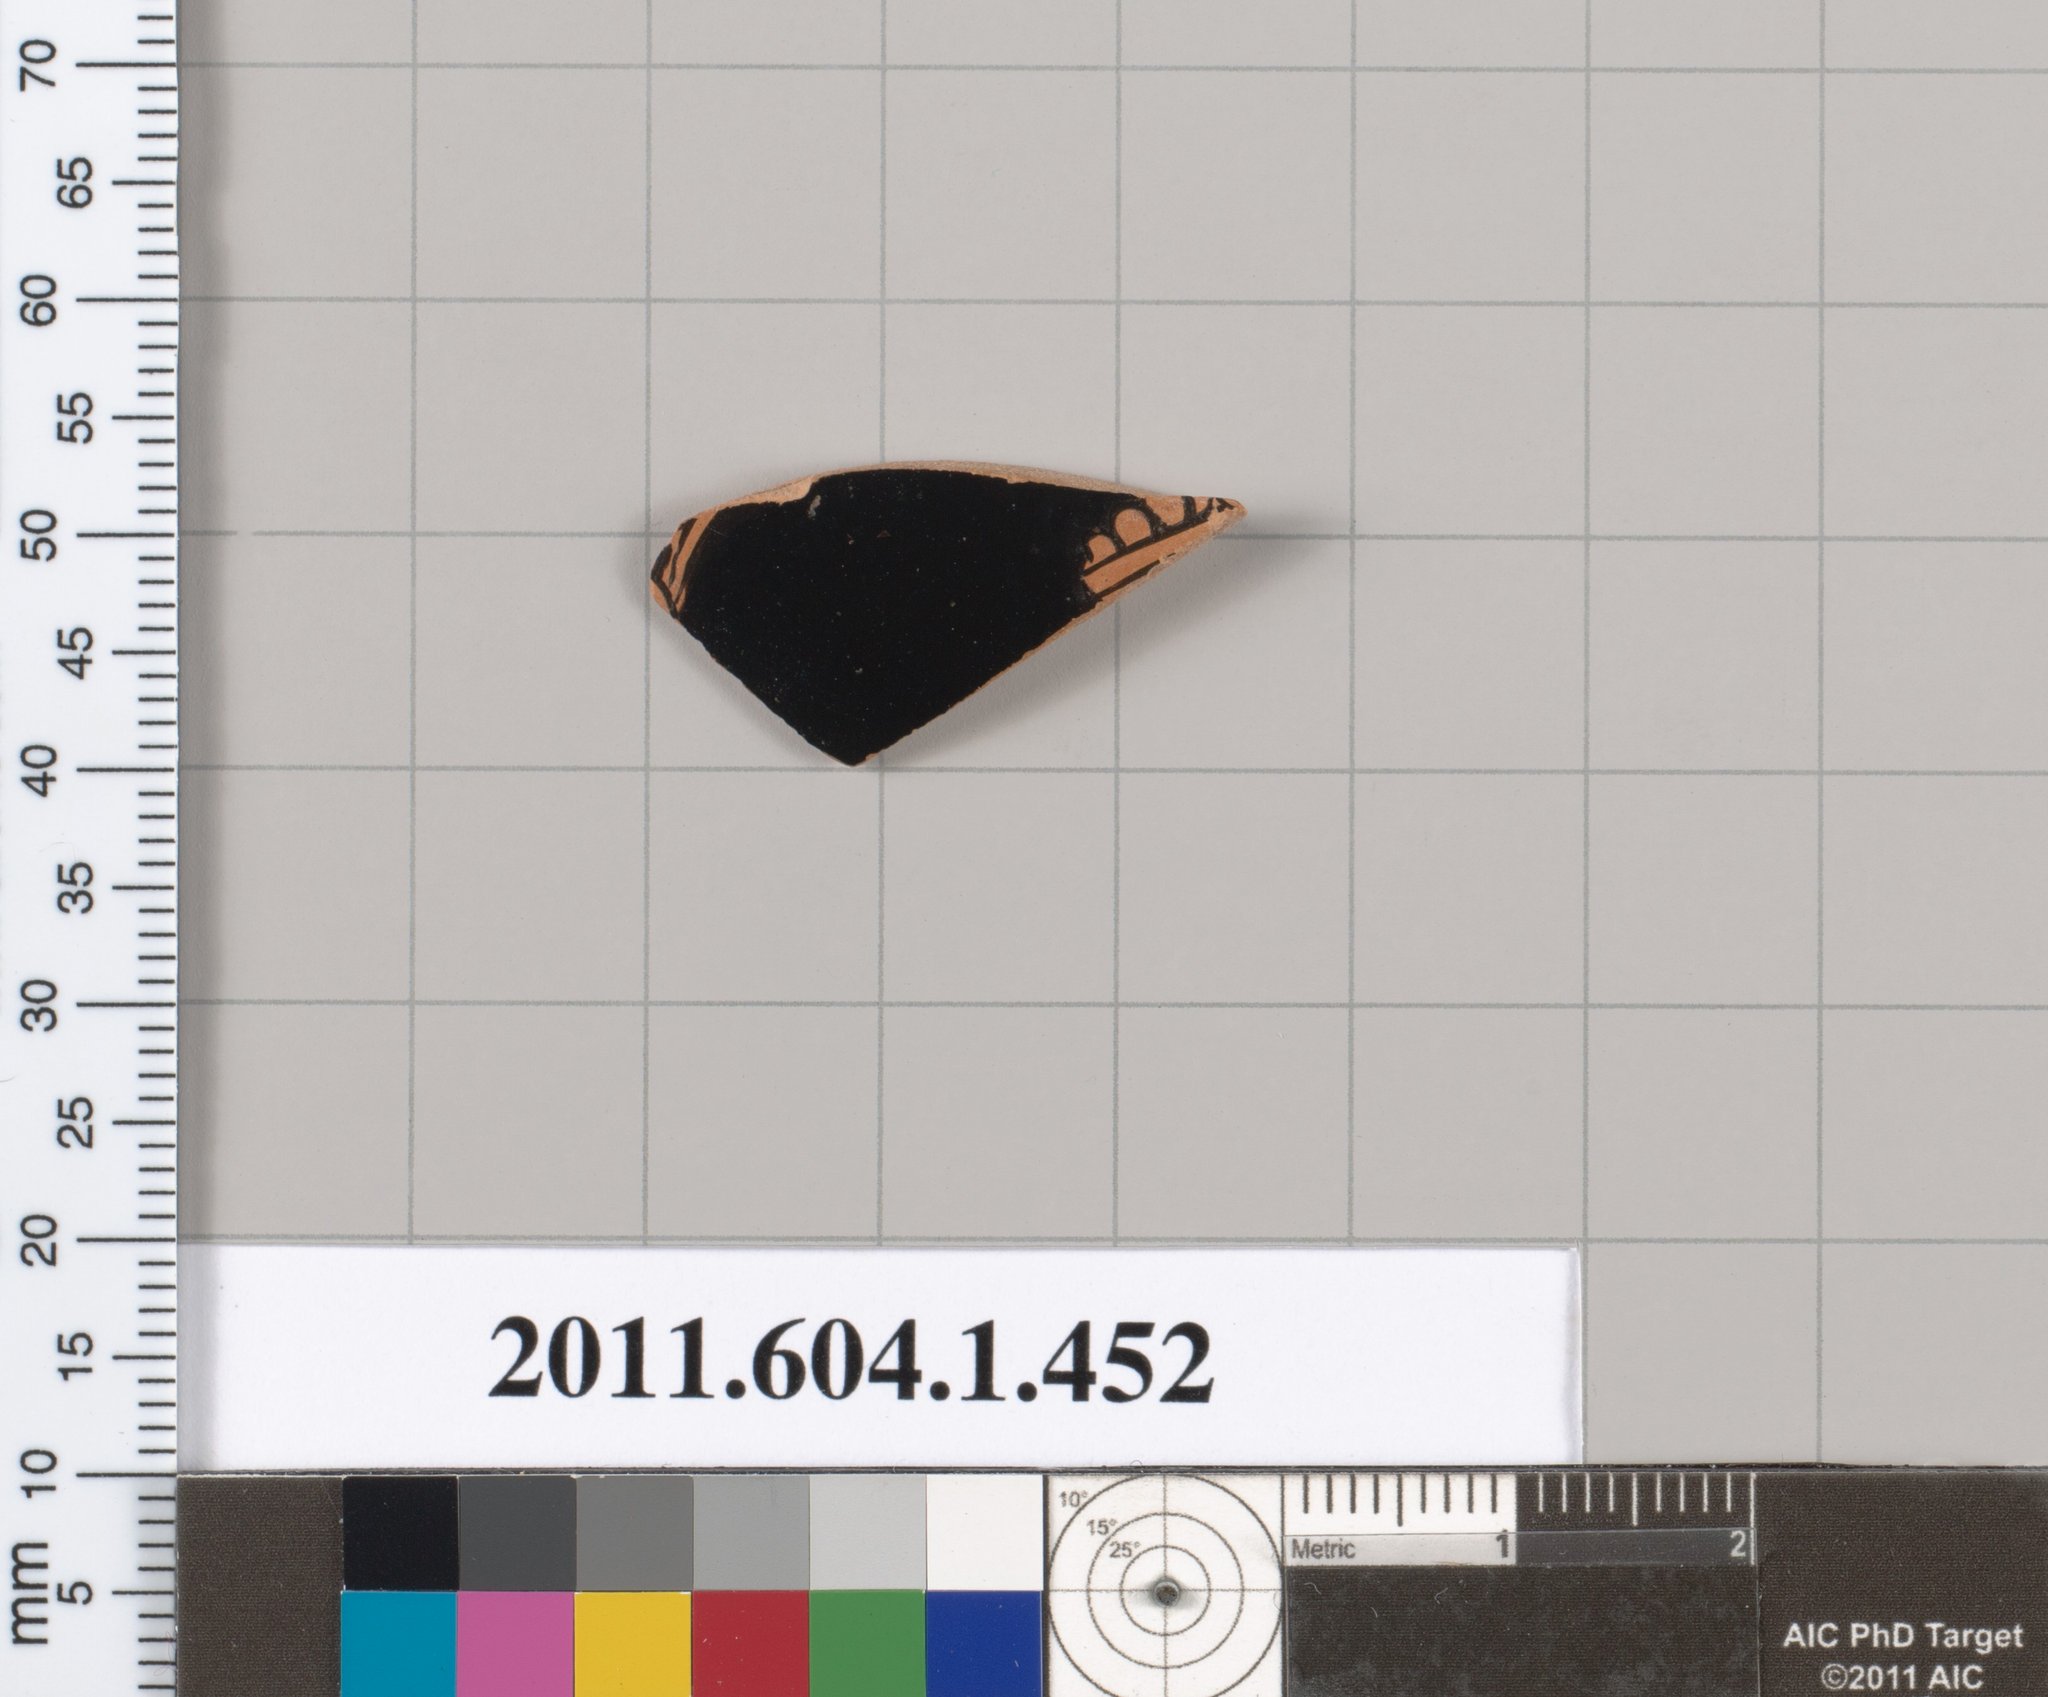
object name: kylix fragment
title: Terracotta fragment of a kylix (drinking cup)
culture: greek, attic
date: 475-451 BCE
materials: terracotta